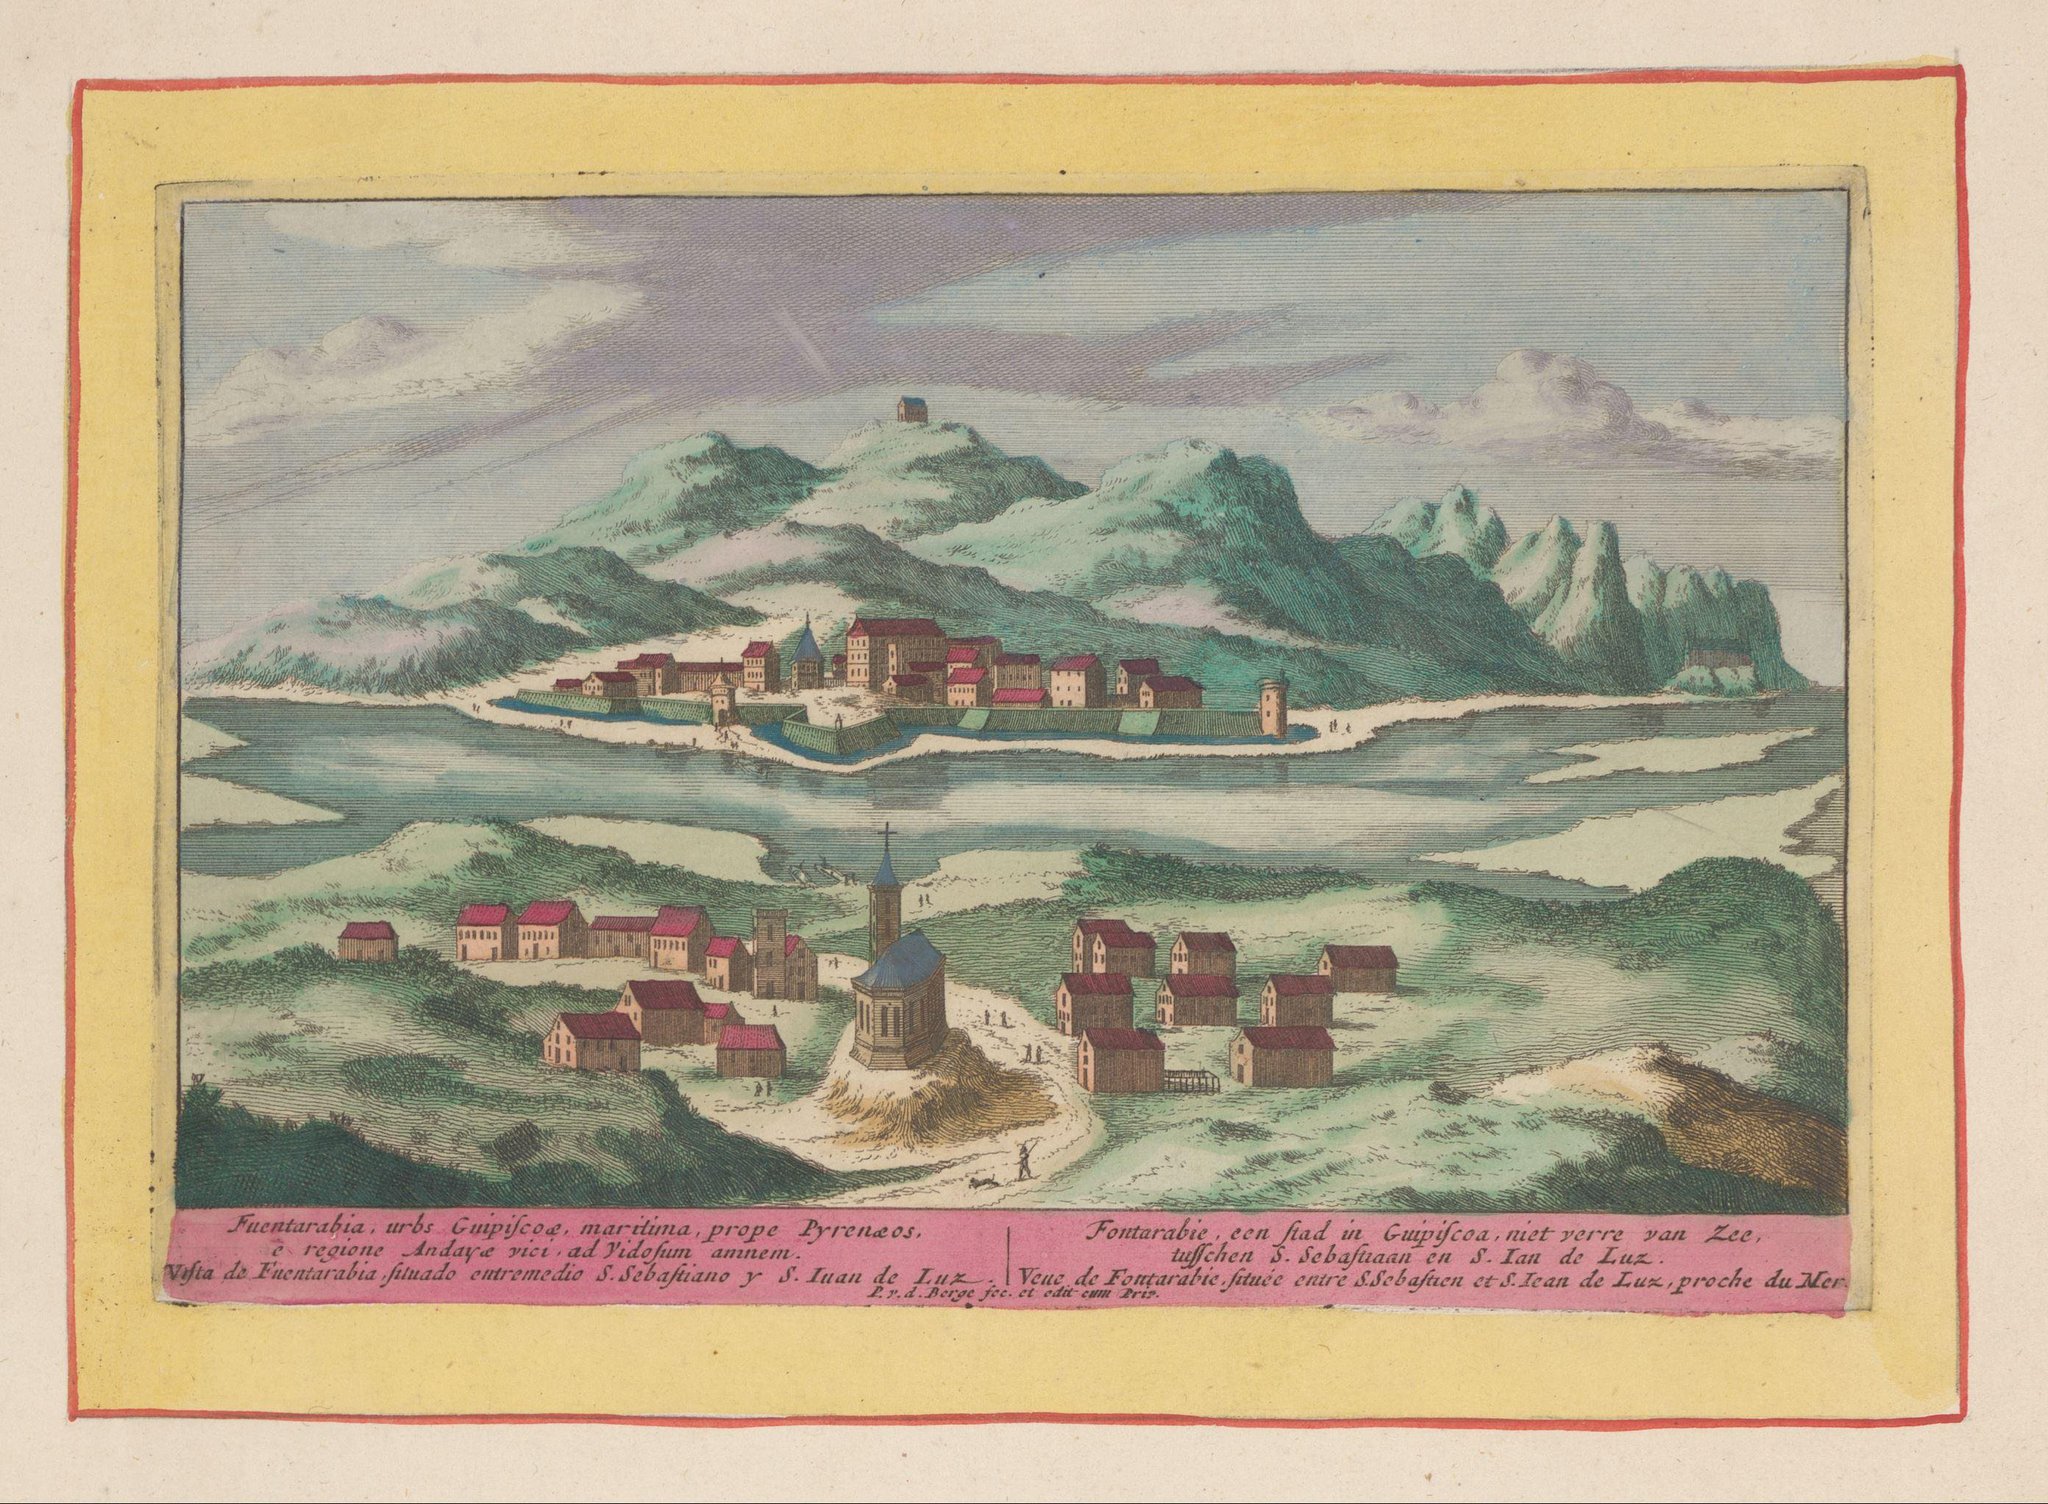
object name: album leaf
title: Gezicht op Fuenterrabía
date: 1694-1737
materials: paper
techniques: etching, hand coloring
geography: amsterdam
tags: prospect of city, town panorama, silhouette of city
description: Prent uit: Theatrum Hispaniæ, exhibens regni urbes, villas ac viridaria magis illustria. Het aanmerkelykste en voortreffelykste in Spanjen (...). Amsterdam: Pieter van den Berge, ca. 1694-1737.